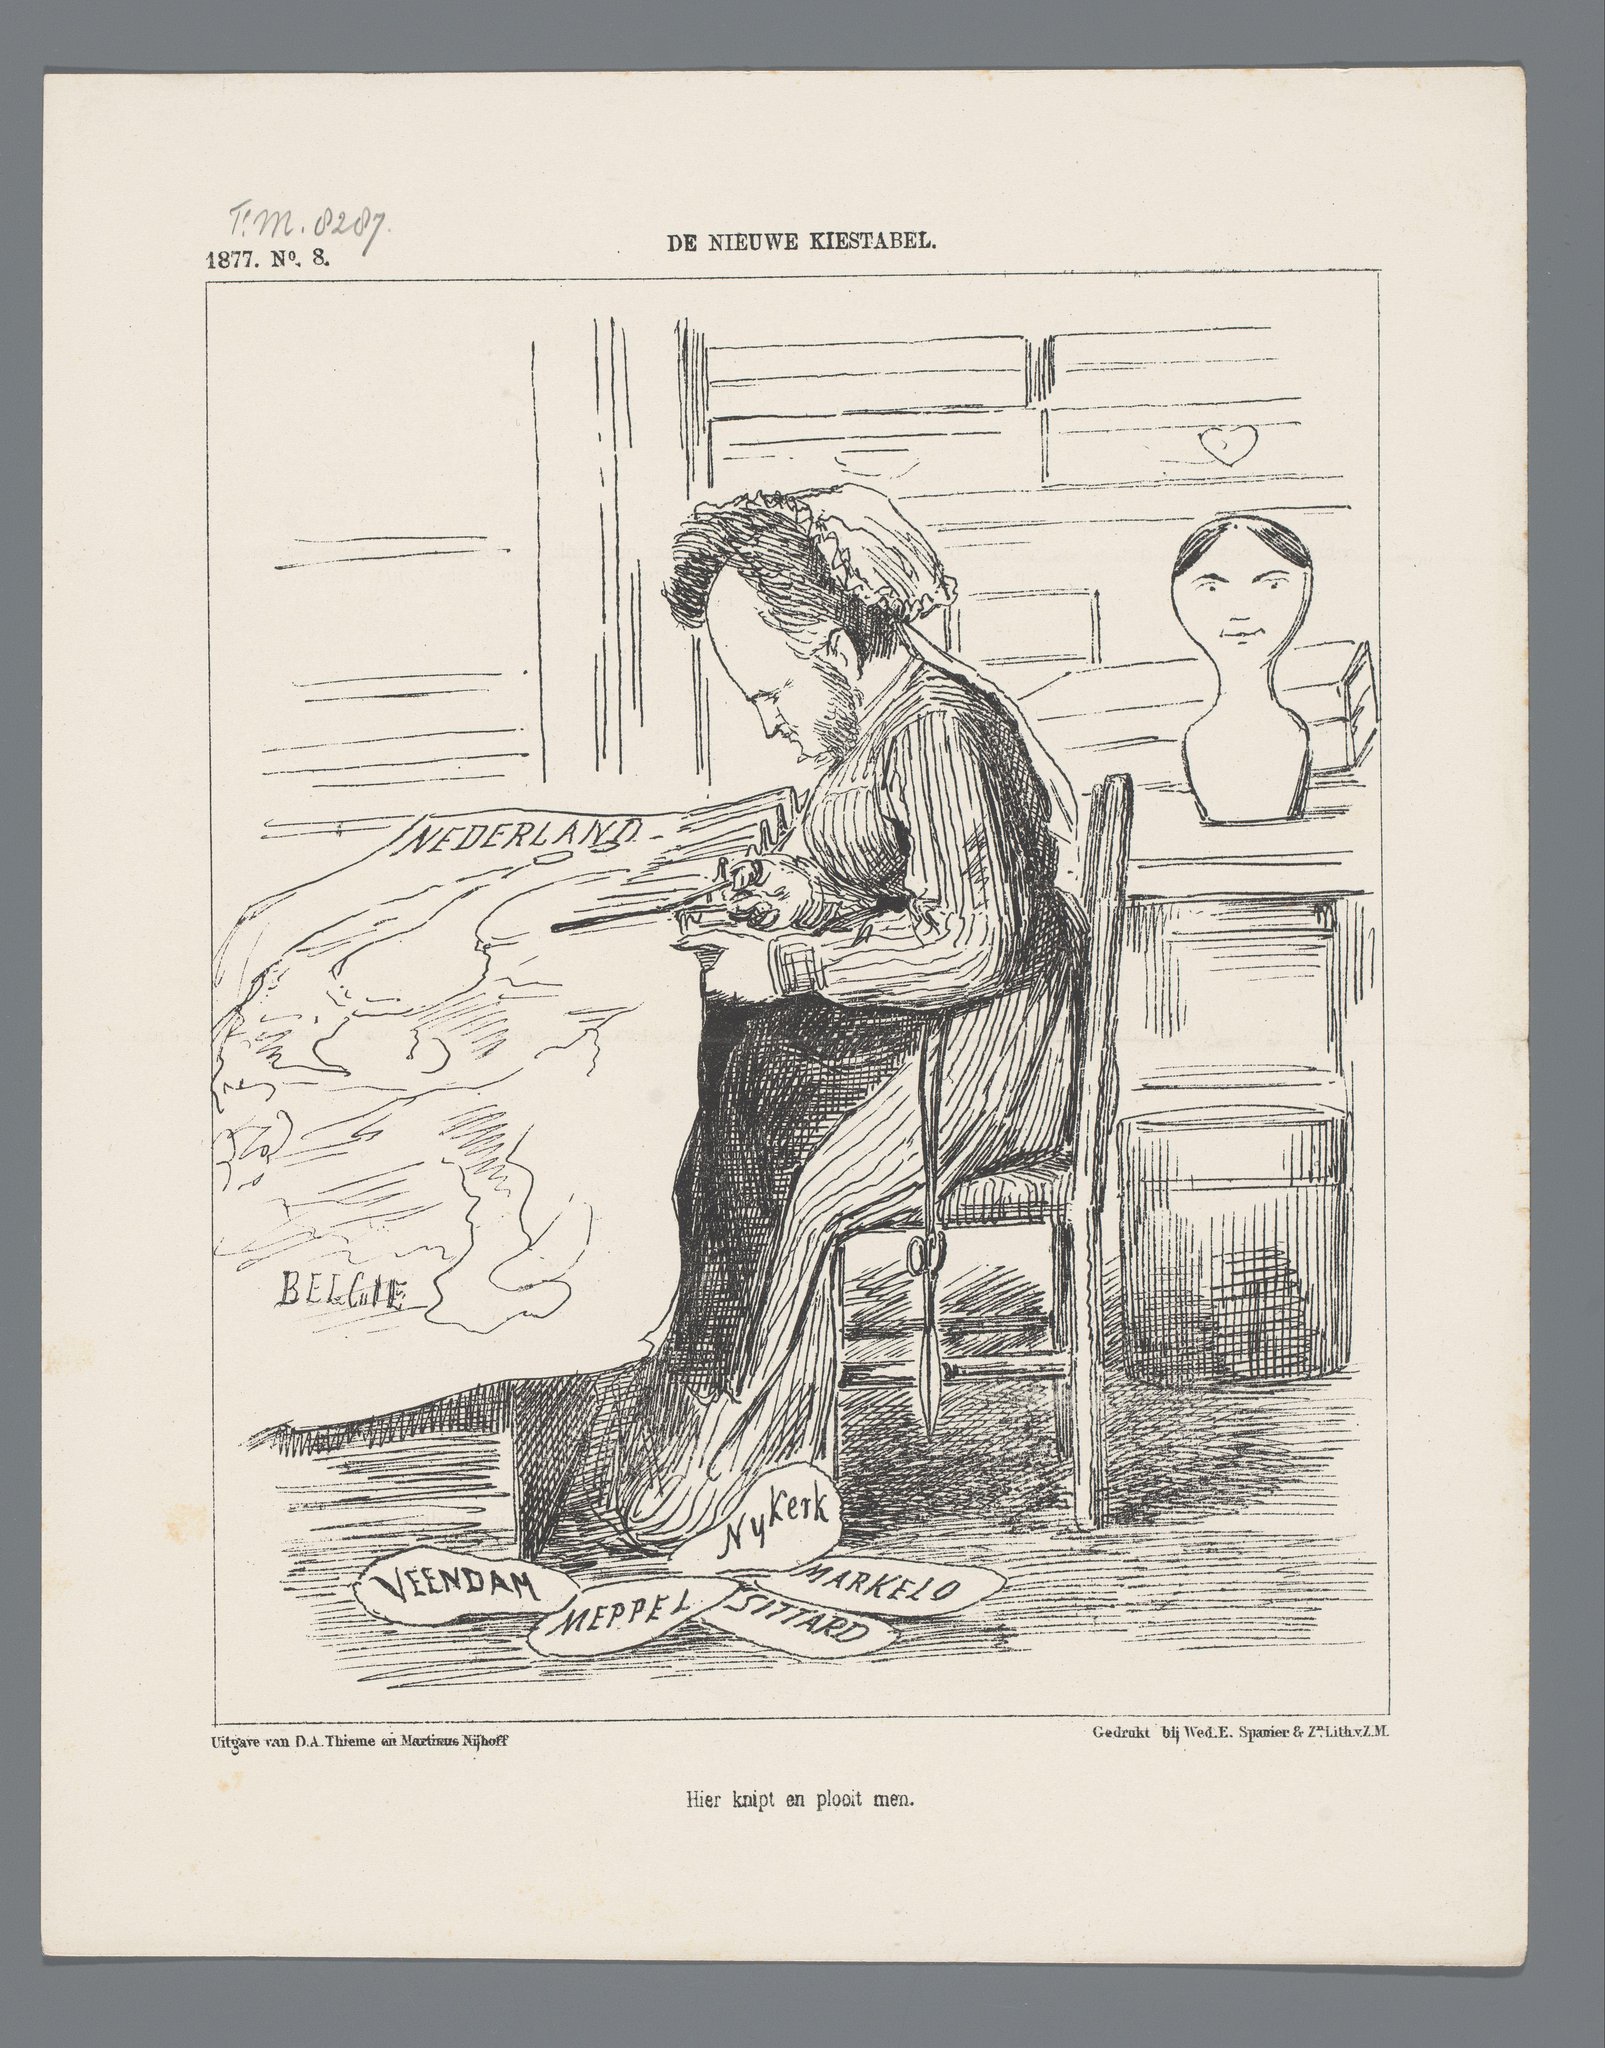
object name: cartoon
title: Spotprent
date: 1877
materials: paper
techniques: lithograph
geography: the hague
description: Spotprent . Plaat verschenen bij het weekblad De Nederlandsche Spectator, nr. 8, 1877.